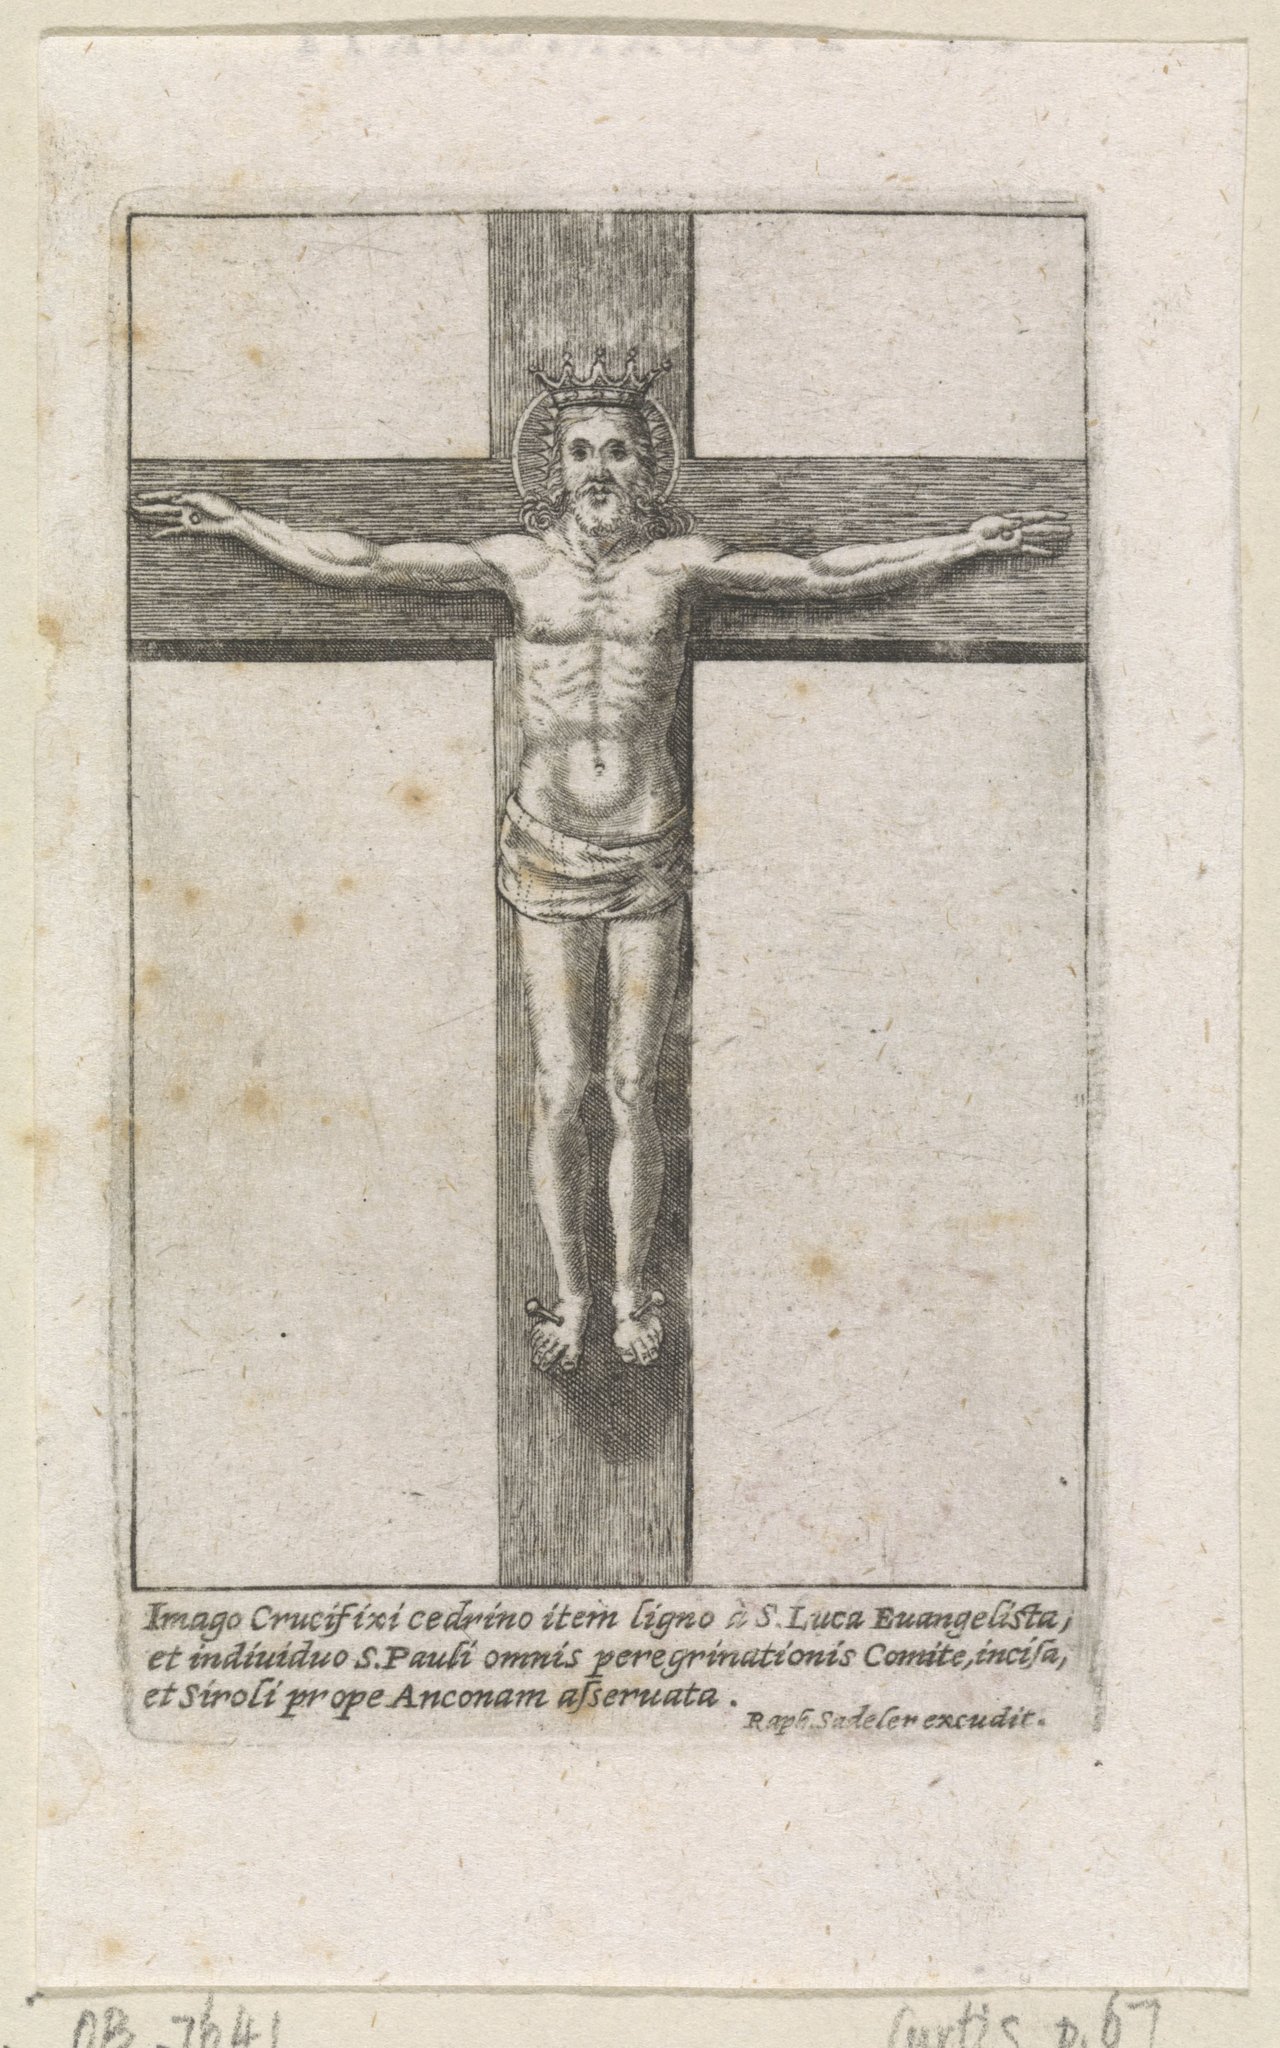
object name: print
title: Gekroonde Christus aan het kruis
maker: wilhelm eder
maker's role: publisher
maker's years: -1660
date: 1622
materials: paper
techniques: engraving, letterpress printing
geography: ingolstadt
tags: crown (symbol of sovereignty), specific forms of the cross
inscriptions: collector's mark: Lugt 240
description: Prent uit: Curtis, Cornelius. De clavis dominicis liber. Ingolstadt en München: Wilhelm Eder en Raphaël Sadeler (I) of (II), 1622.